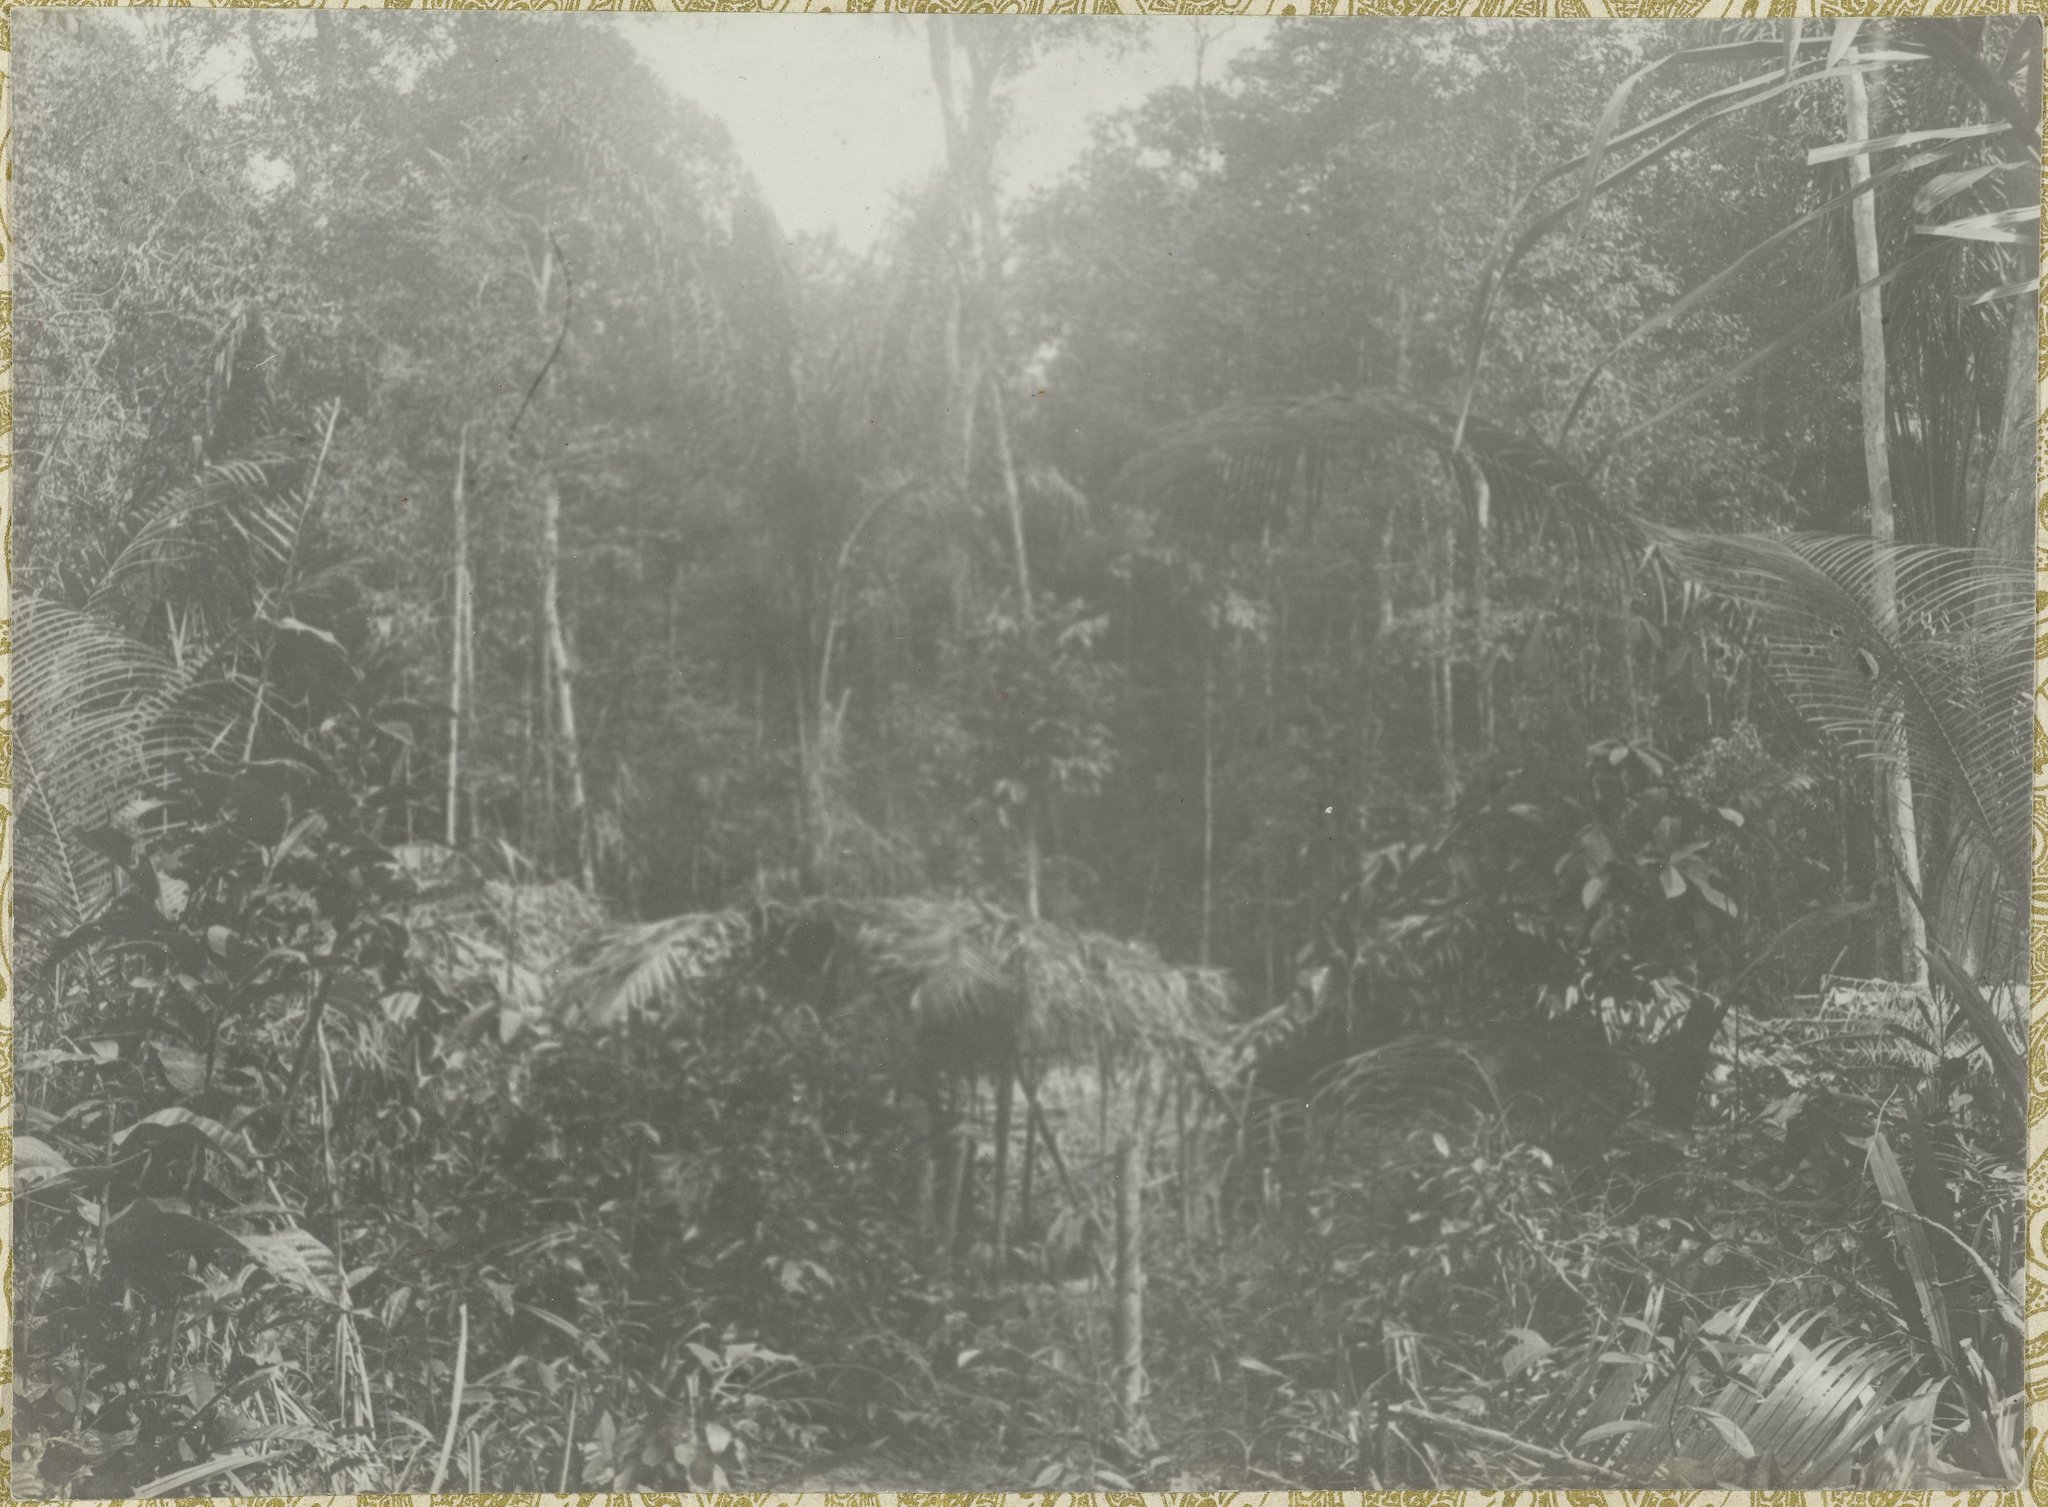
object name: photograph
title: Oerwoud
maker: hendrik doijer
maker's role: engineer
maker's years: 1863-1925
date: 1903-1910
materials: photographic support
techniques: gelatin silver print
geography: suriname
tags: suriname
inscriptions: inscription: ‘Vergrooting van’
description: Gezicht in het Surinaamse oerwoud. Onderdeel van het fotoalbum Souvenir de Voyage (deel 1), over het leven van de familie Doijer in en rond de plantage Ma Retraite in Suriname in de jaren 1903-1910.